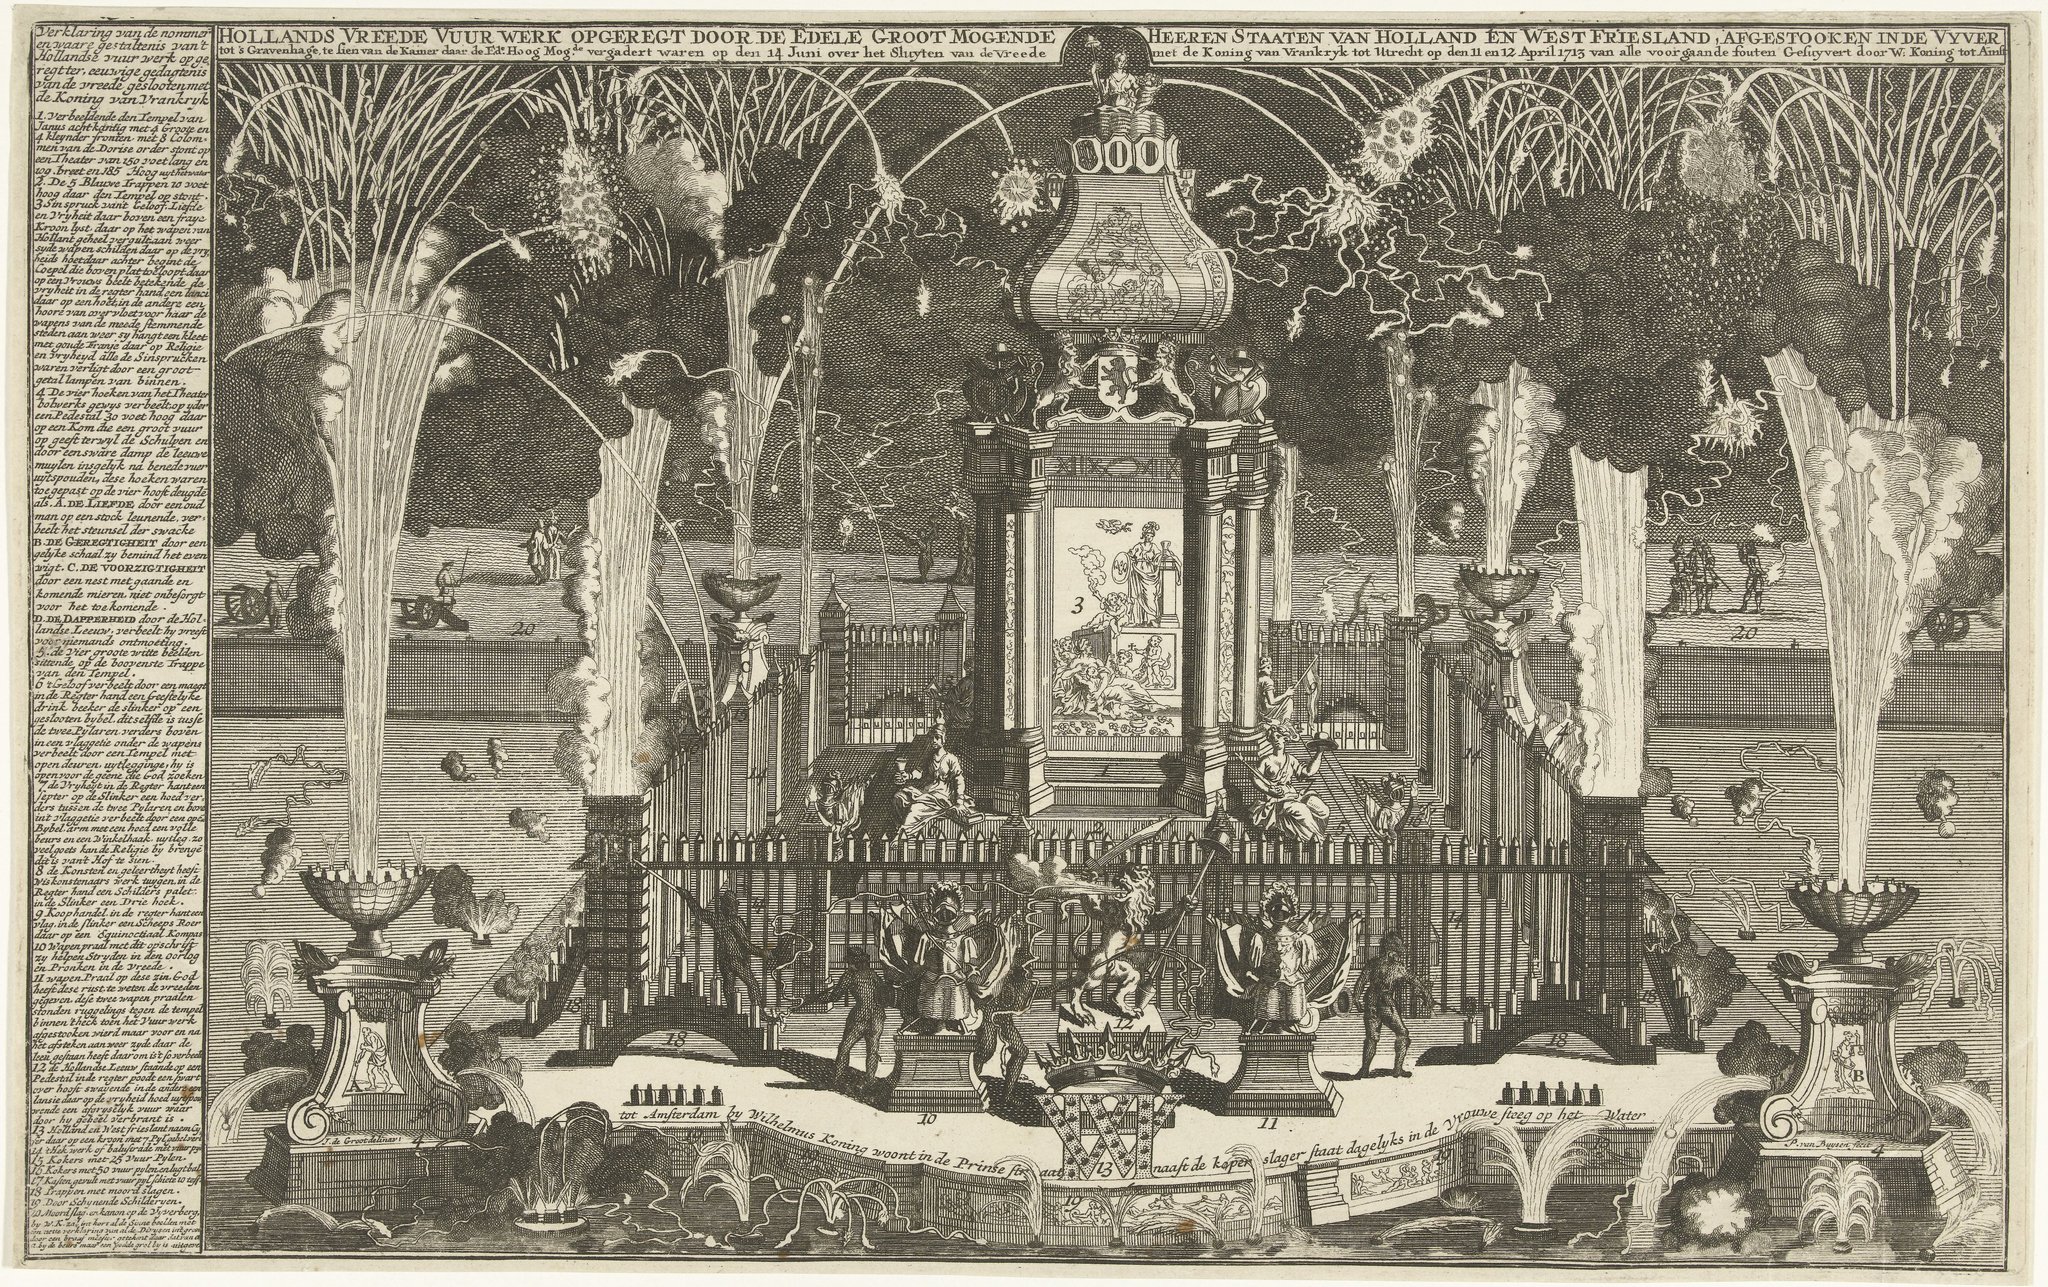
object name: print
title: Hollands Vreede Vuur Werk opgeregt door de Edele Groot Mogende Heeren Staaten van Holland en West Friesland, afgestooken in de vyver tot 's Gravenhage (...)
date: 1713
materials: paper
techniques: etching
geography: amsterdam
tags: bonfire, fire-works (+ illumination, fire-works ~ festive activities)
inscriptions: collector's mark: Lugt 2228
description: Stellage met vuurwerk afgestoken in opdracht van de Staten van Holland en West-Friesland op de Hofvijver te 's-Gravenhage bij de viering van de Vrede van Utrecht, 14 juni 1713. Centraal de tempel van Janus bekroond door de Hollandse Maagd met vrijheidshoed in de Hollandse Tuin. De Tempel omringd door zittende figuren van Geloof, Vrijheid, Koophandel, Wetenschap en de Kunsten. Links de verklaring van de cijfers 1-20 in het Nederlands. Hierbij in de laatste regel de vermelding van uitgever Wilhelmus Koning dat hij binnenkort een verklaring van de zinnebeelden zal doen uitgeven waarbij dat van A.A. (= Abraham Allard) "maar een podde grol by is".